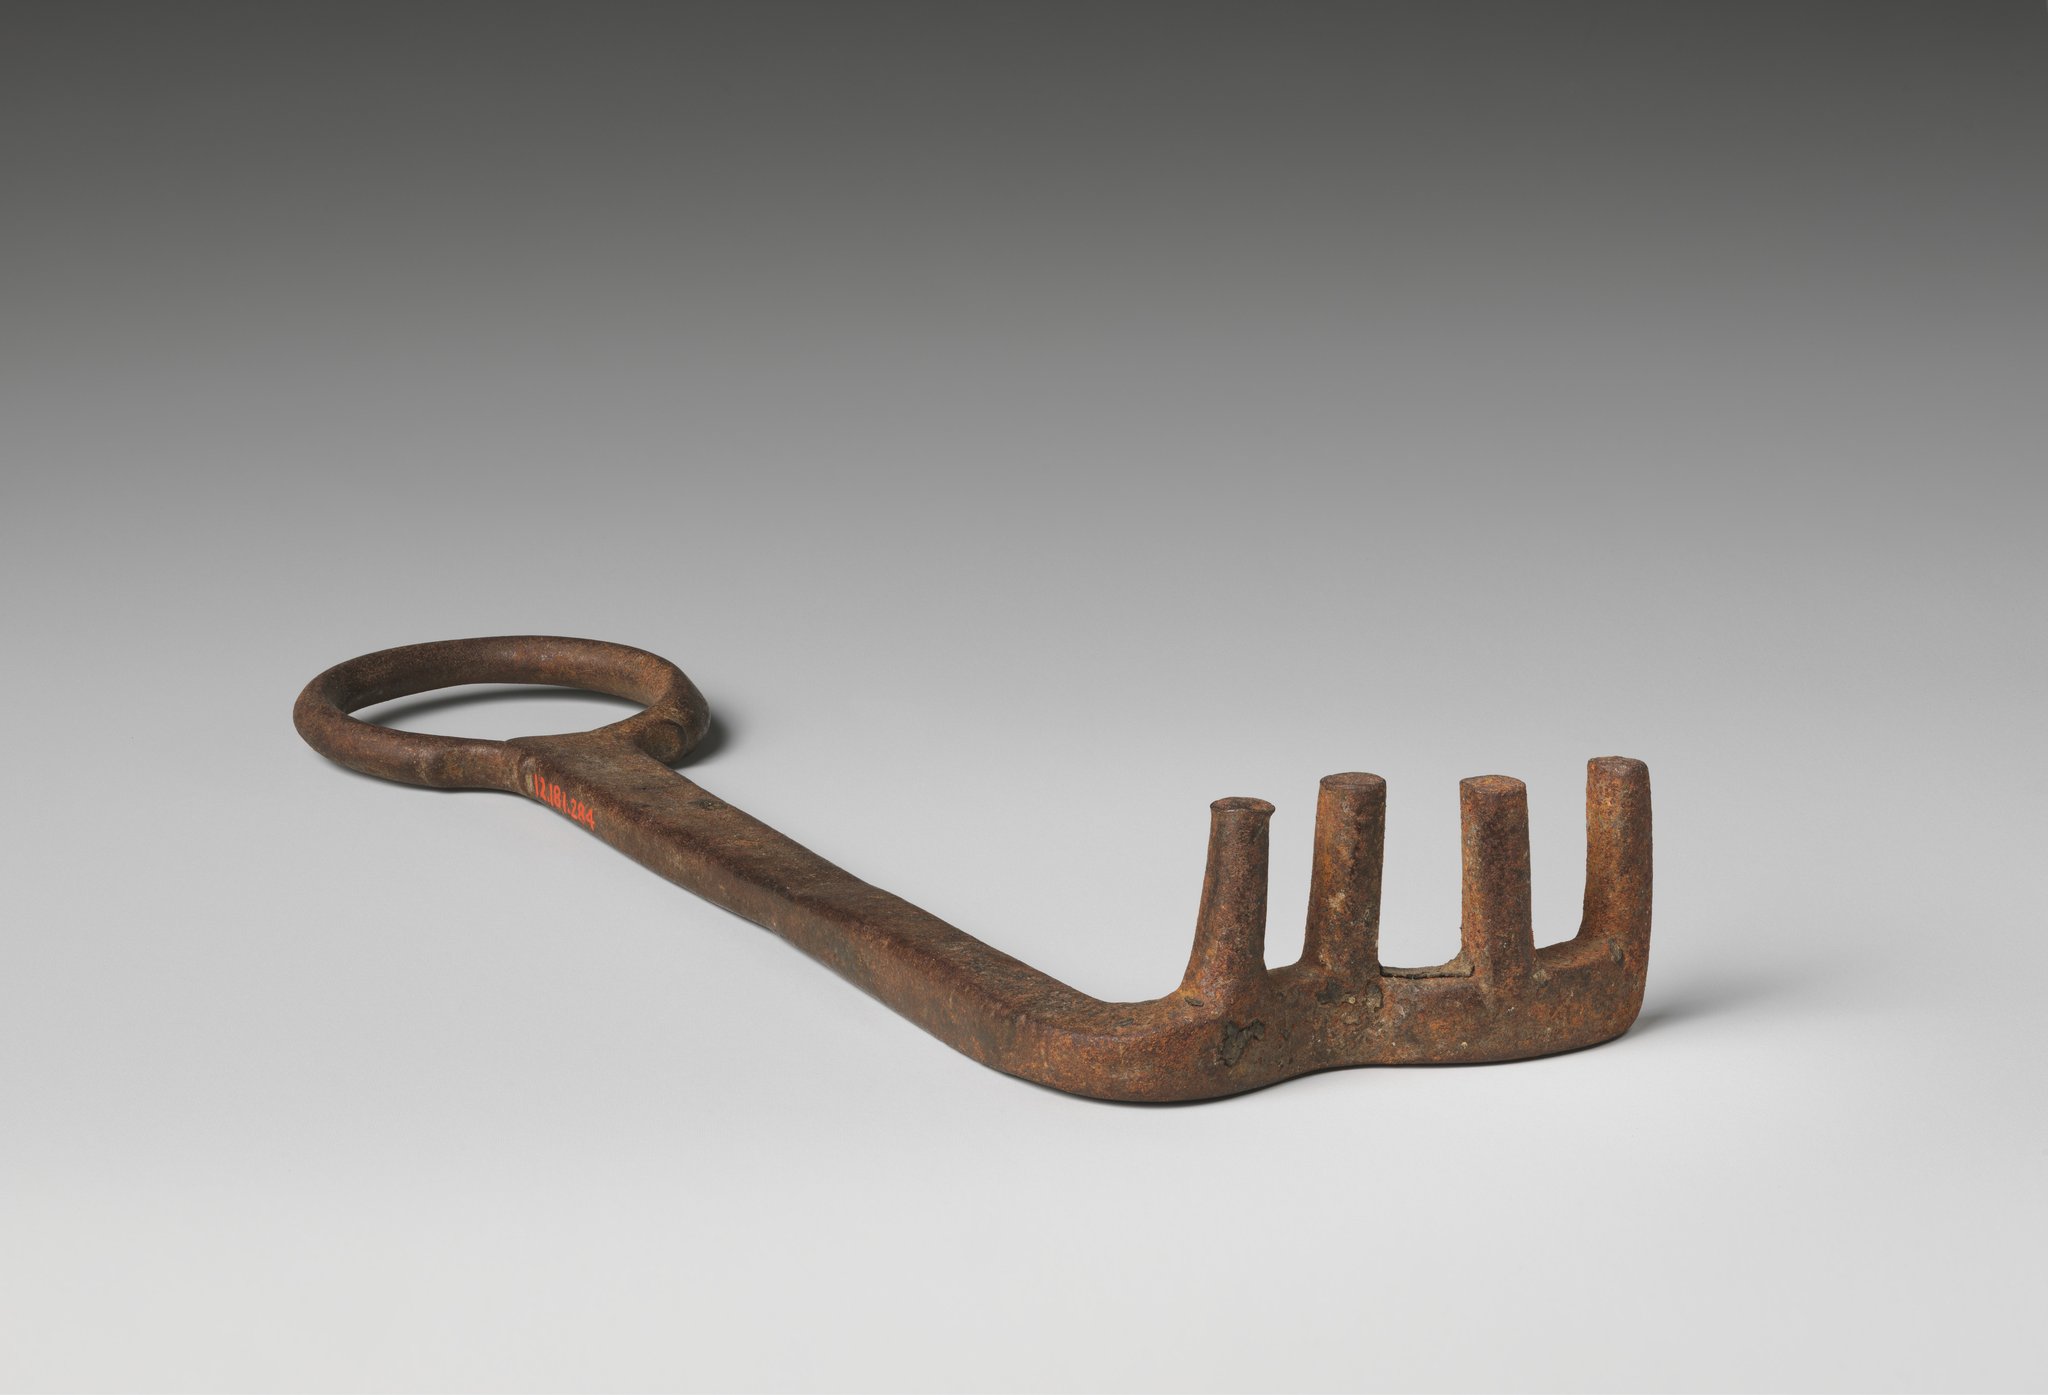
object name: key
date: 306-30 BCE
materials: iron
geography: egypt